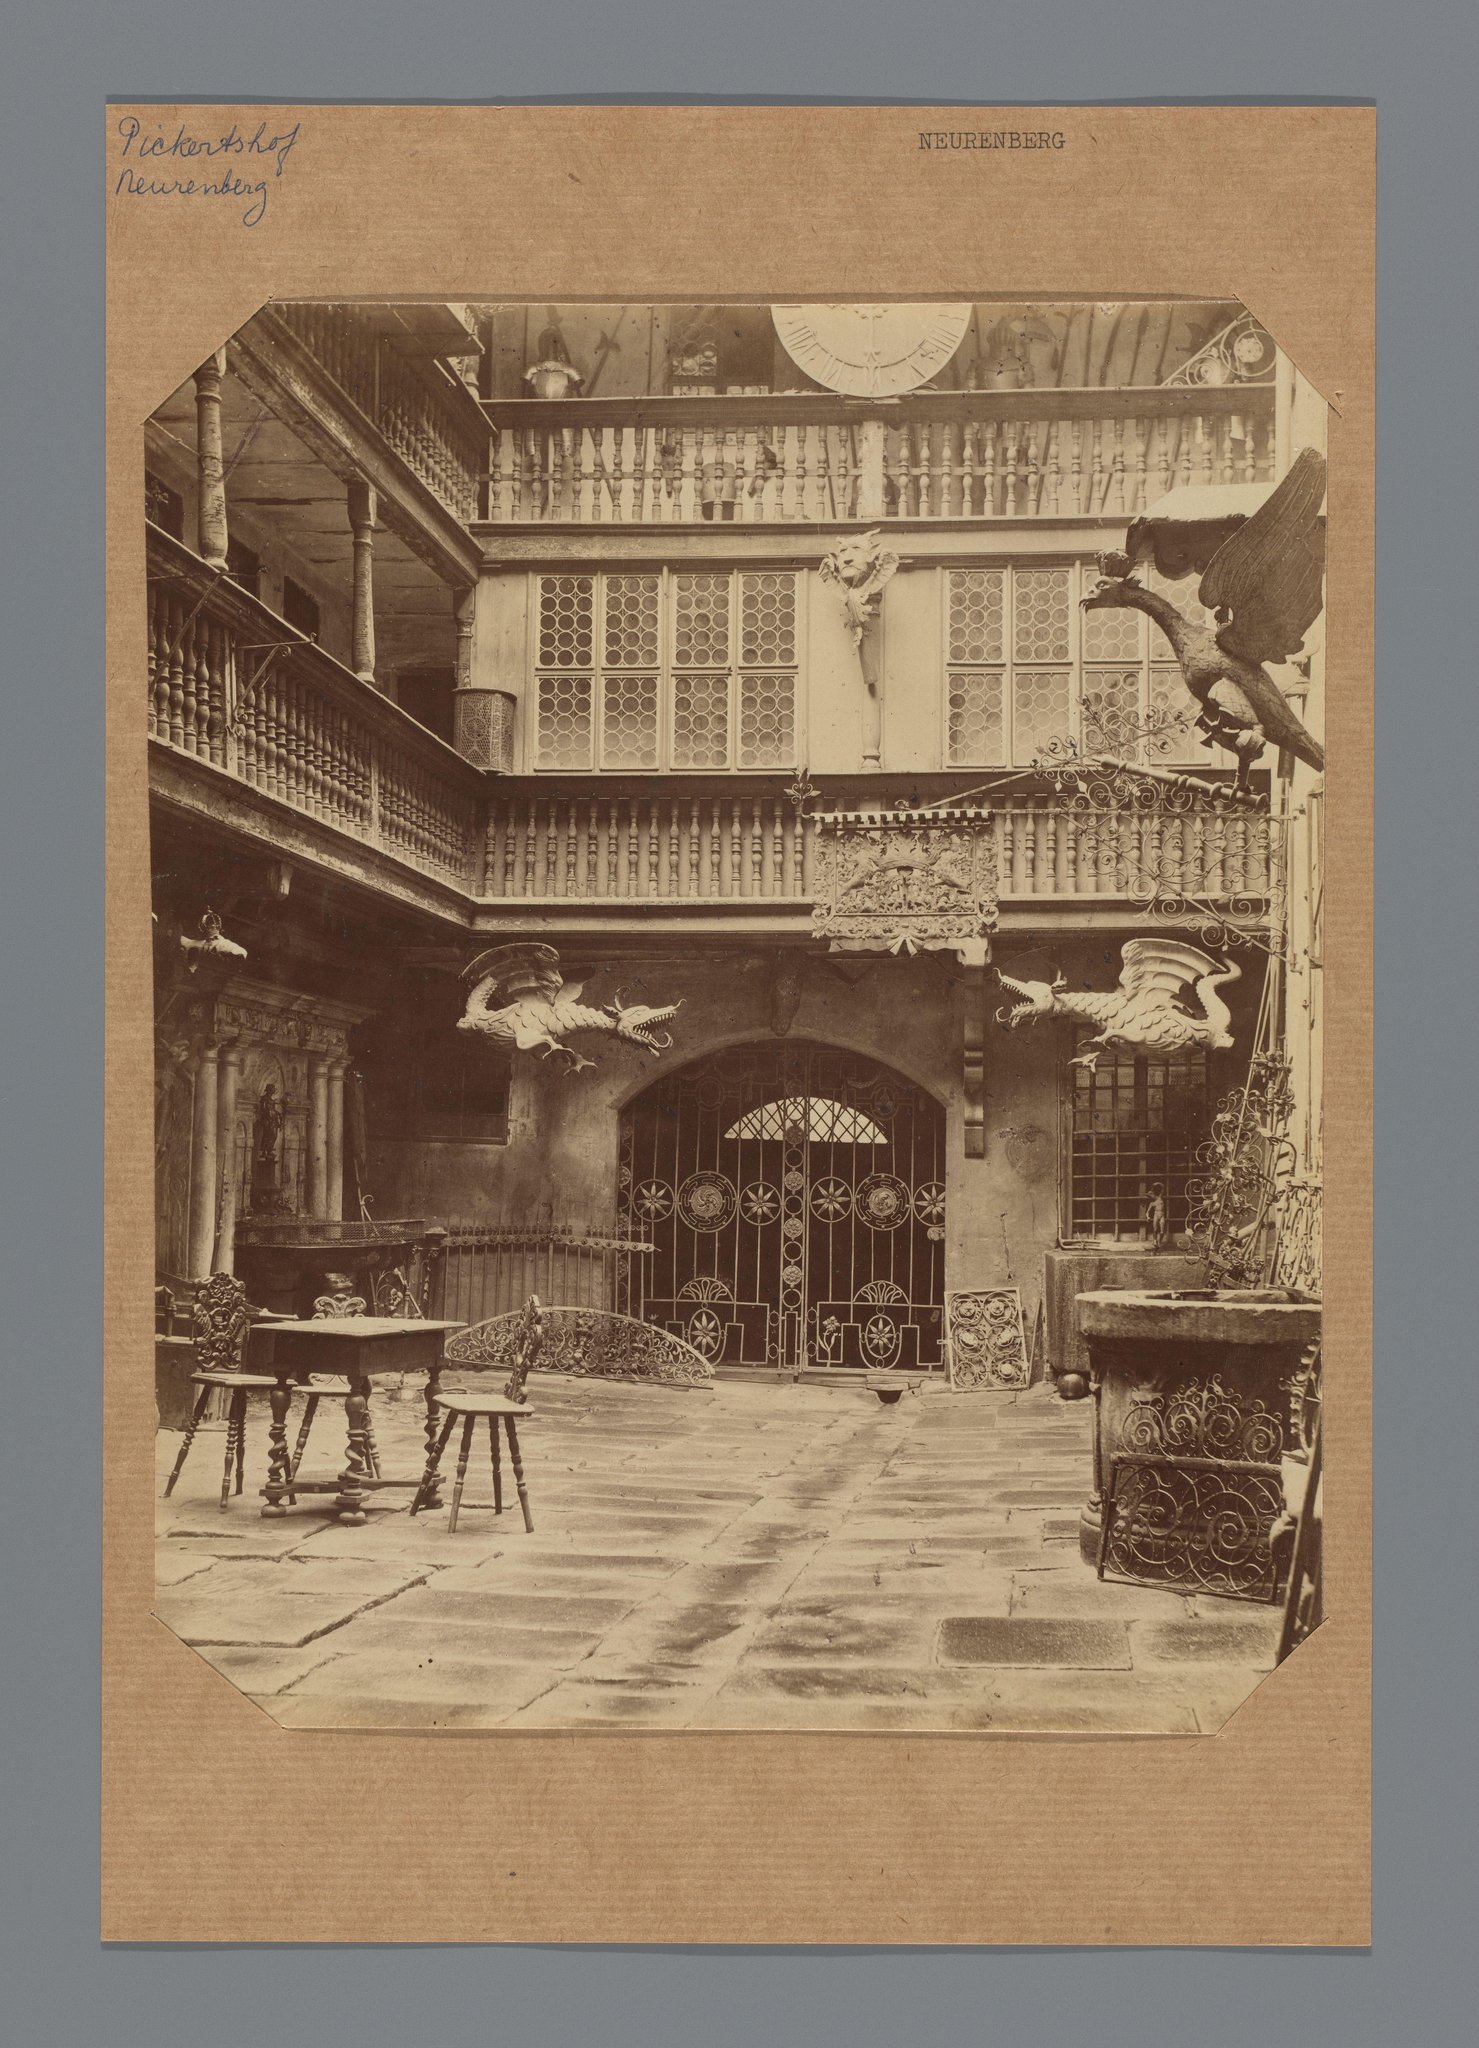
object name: photograph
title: Neurenberg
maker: Anonymous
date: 1850-1900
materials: photographic support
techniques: albumen print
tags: neurenberg